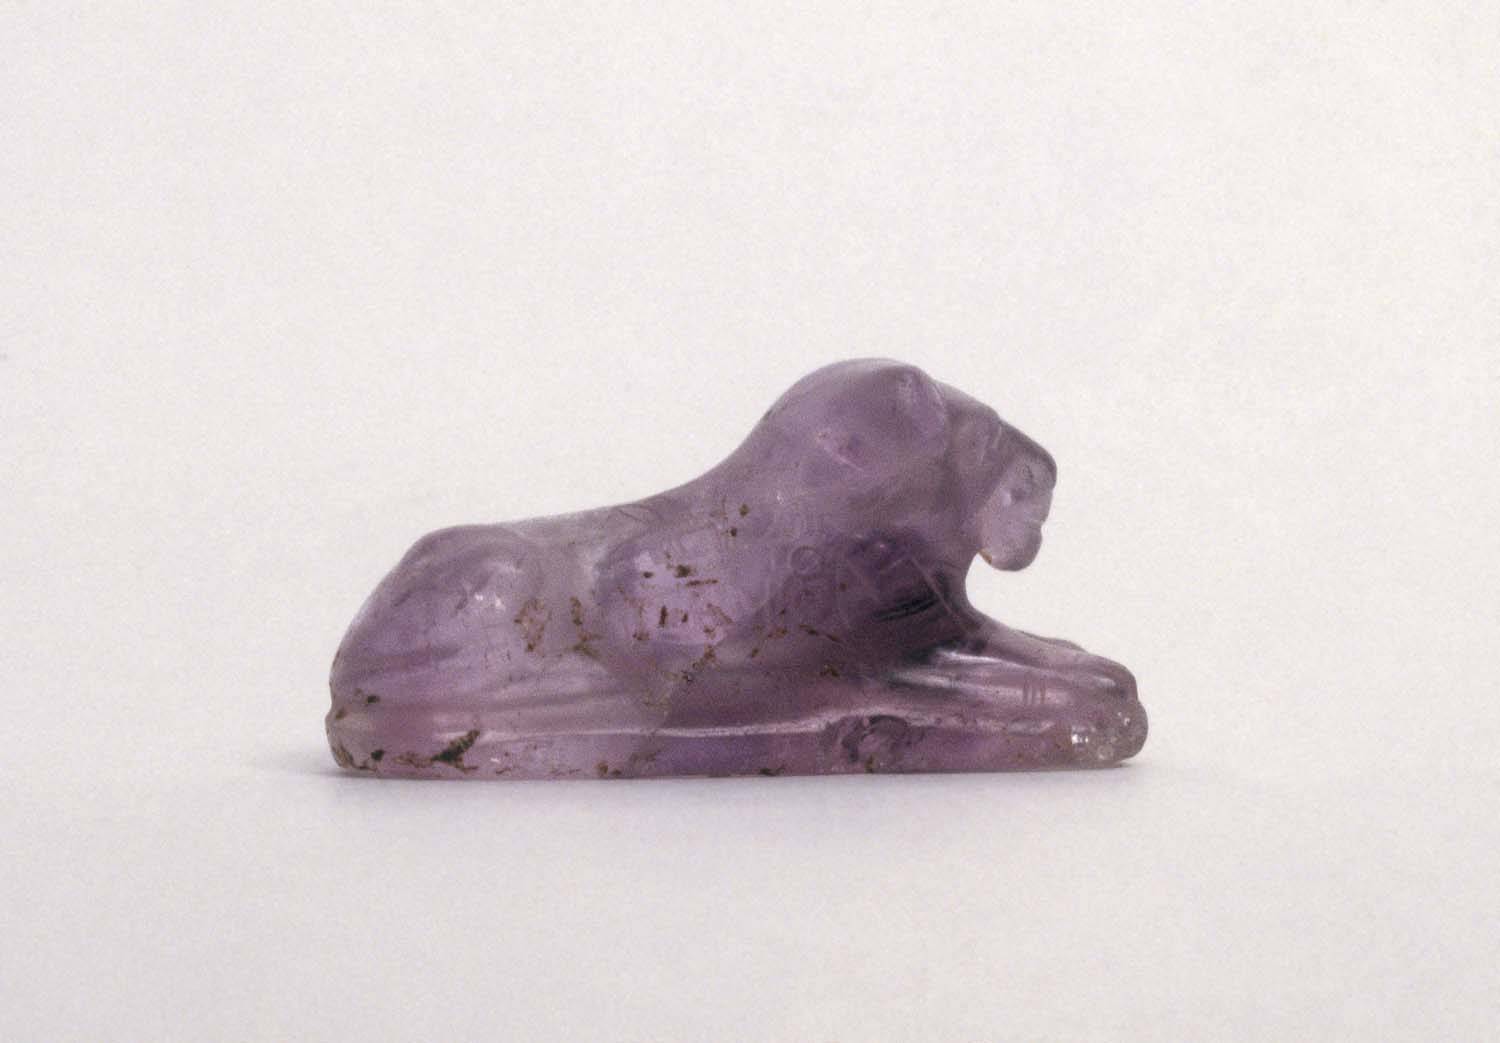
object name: amulet, lion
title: Lion Amulet, Perforated Lengthwise, Inscribed with the Name of Senwosret I and the Epithet "Beloved by the Souls [Ancient Rulers or Gods] of Heliopolis"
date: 1961-1917 BCE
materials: gemstone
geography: egypt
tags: lions